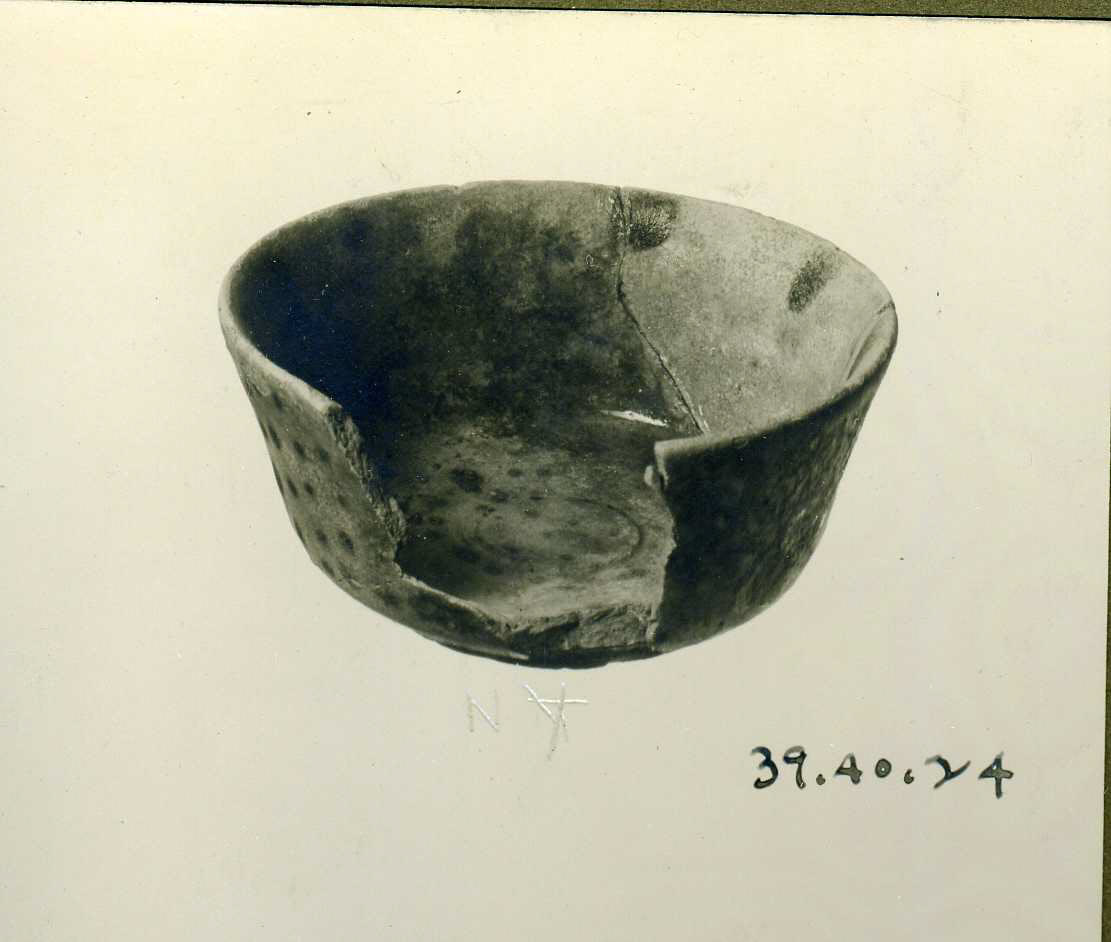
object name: bowl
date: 701-900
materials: earthenware, glaze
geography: iran